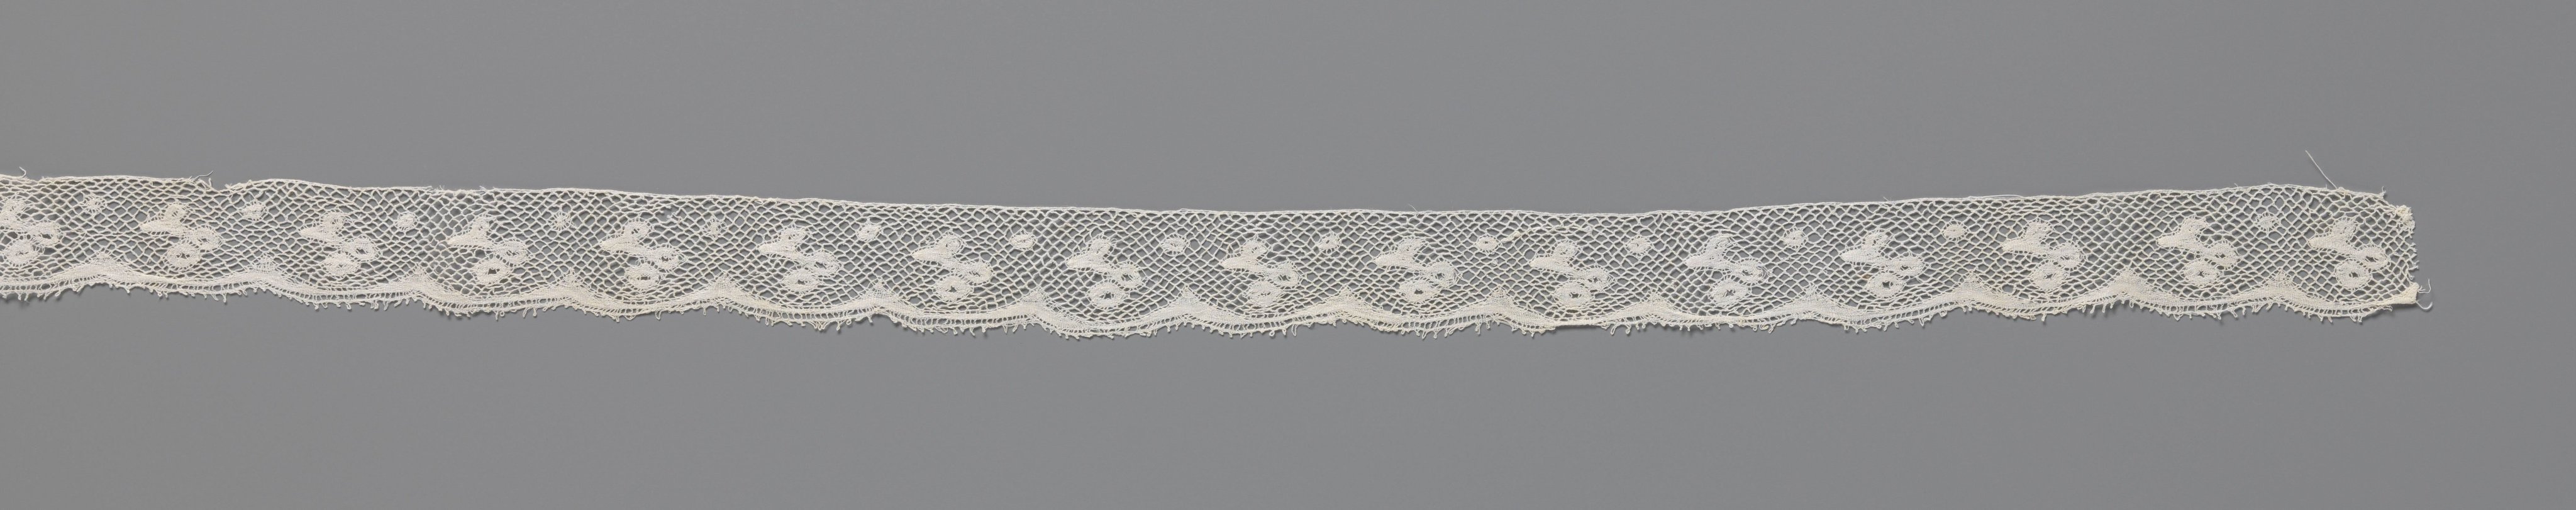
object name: strip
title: Strook kloskant met twee besjes aan een takje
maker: Anonymous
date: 1875-1899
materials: linen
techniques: lace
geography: belgium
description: Op een fond van vierkante mazen staan boven een gesloten schulprand stijve takjes, waaraan twee besjes groeien. Tussen elk takje is een moesje geplaatst. Valenciennes-kant.